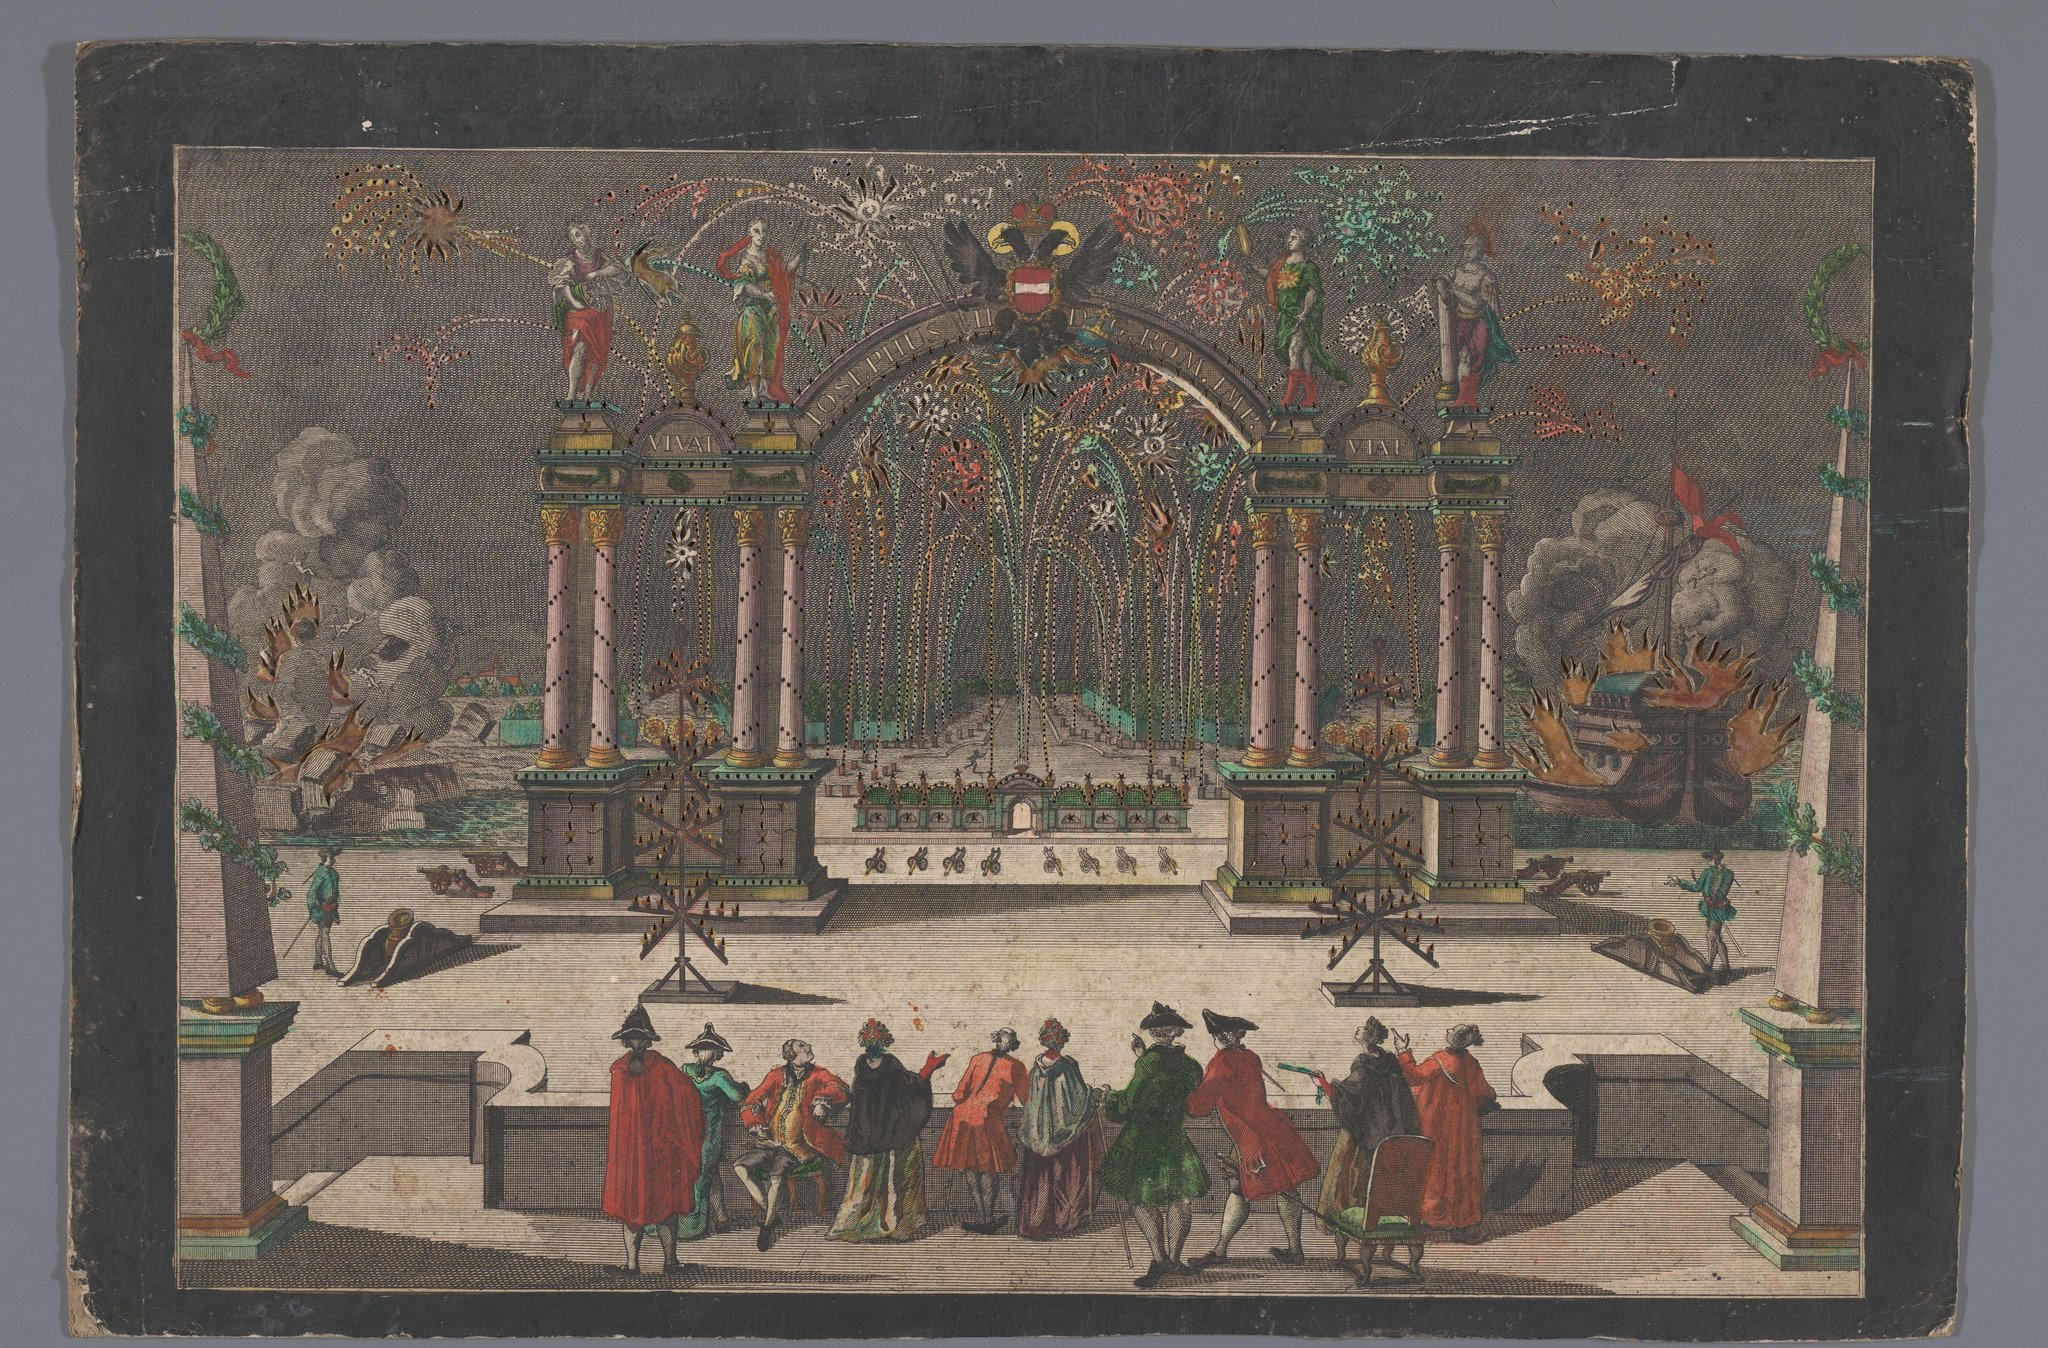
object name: opticaprent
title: Gezicht op vuurwerk en een triomfboog met een tweekoppige adelaar en de naam van Jozef II, Duits keizer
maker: Anonymous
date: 1765-1799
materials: cardboard, paint, paper, watercolor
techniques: brush, cutting, etching, perforating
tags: vienna, jozef ii (duits keizer), double-headed eagle, triumphal arch, bonfire, fire-works, square, place, circus, etc. (+ city(-scape) with figures, staffage)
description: Op de achtergrond links ontploft een bouwwerk met figuren. Op de achtergrond rechts brandt een schip.